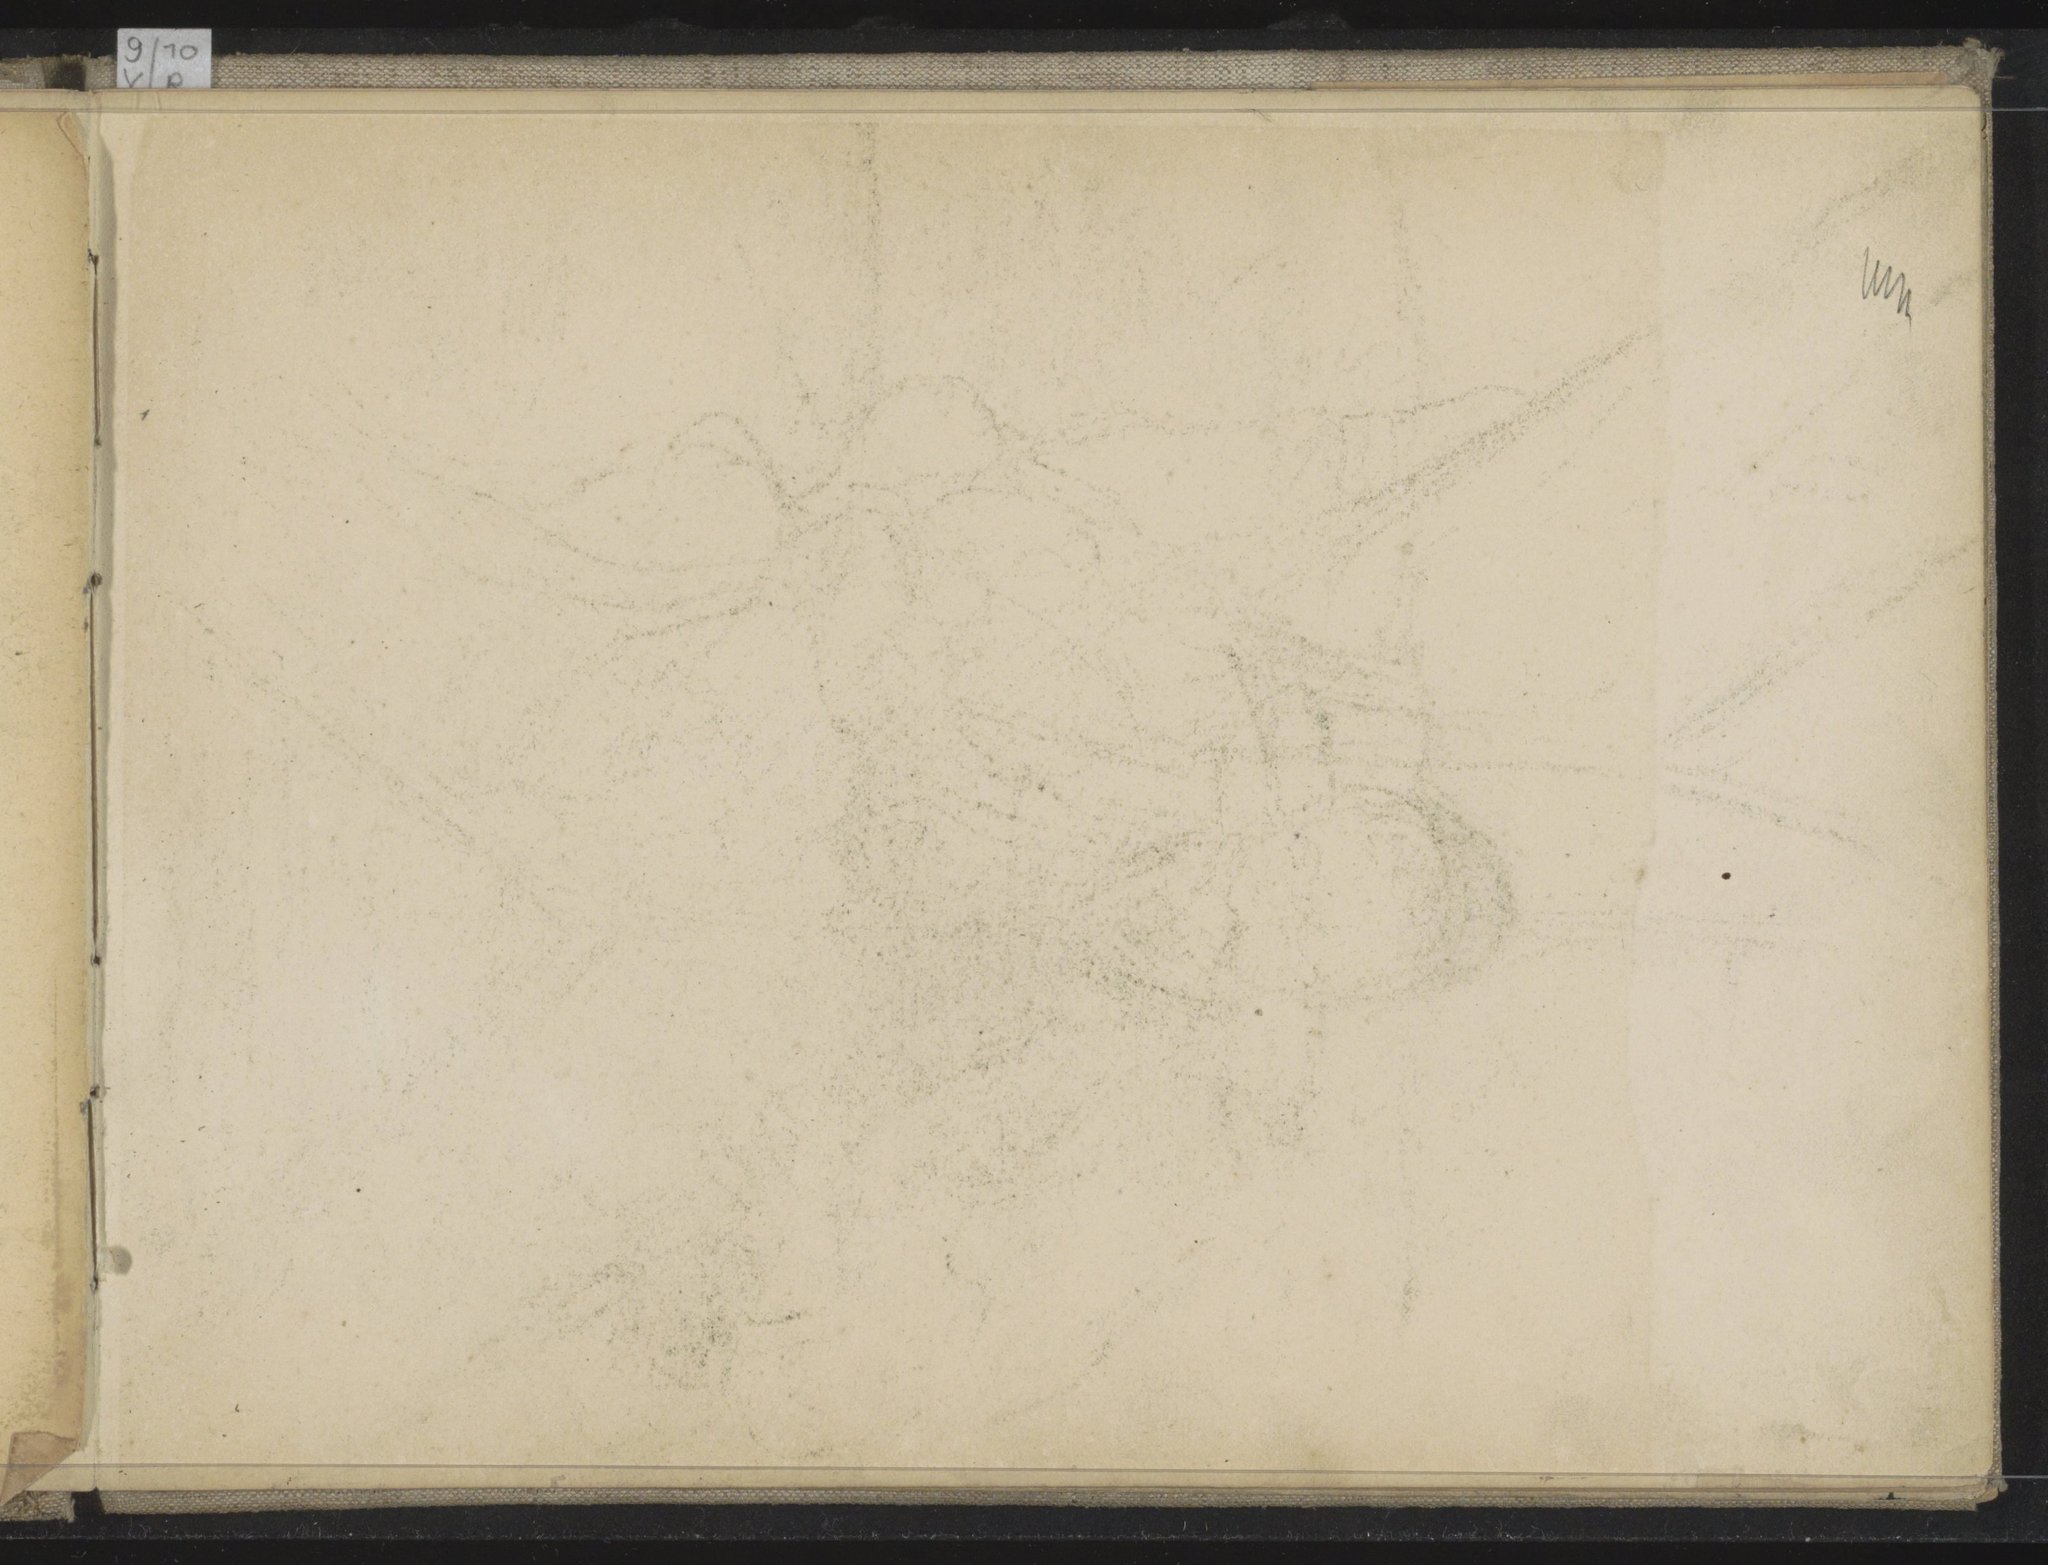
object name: sketchbook leaf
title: Abklatsch van een krijttekening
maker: johanna van de kamer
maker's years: 1873-1922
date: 1890-1922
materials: paper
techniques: printmaking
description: De tekening, die niet langer aanwezig is in het schetsboek, stelt een zittende man voor. Blad 5 recto uit een schetsboek met 11 bladen.